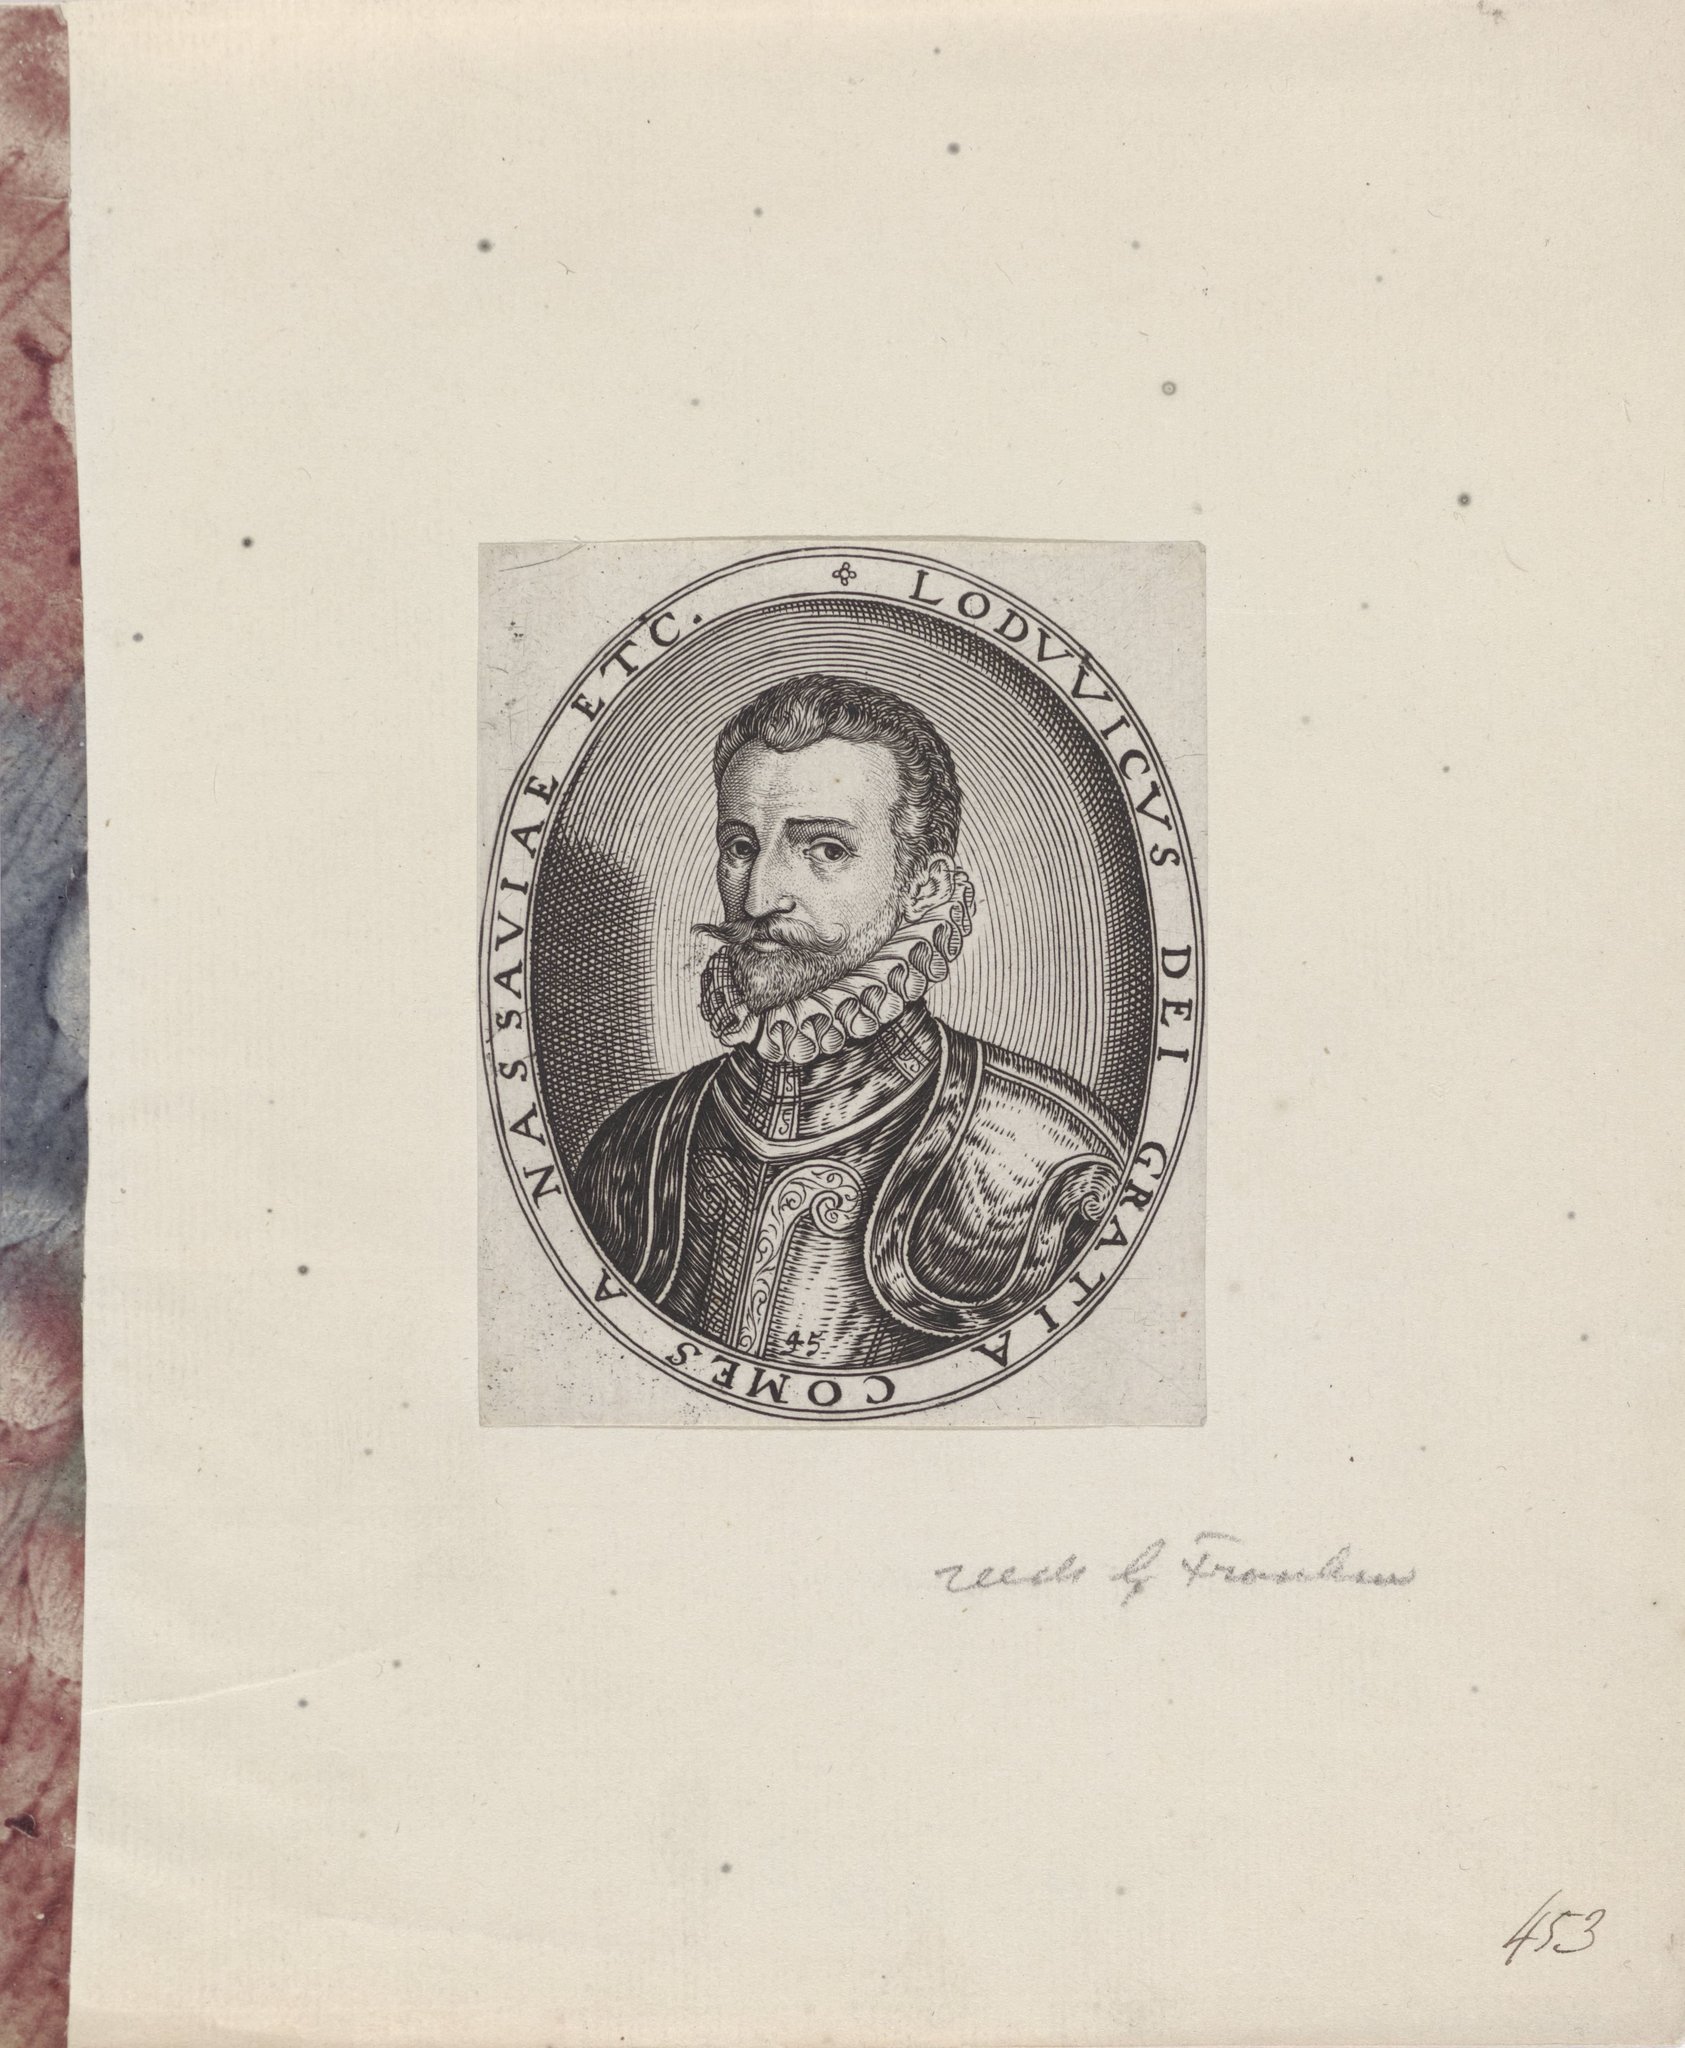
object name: print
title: Portret van Lodewijk, graaf van Nassau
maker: Anonymous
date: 1600-1699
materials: paper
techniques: engraving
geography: low countries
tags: dillenburg, lodewijk graaf van nassau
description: De hier vermelde titel verwijst naar de hoogst verkregen titel van de geportretteerde, niet per se naar de titel die de geportretteerde op deze voorstelling draagt.